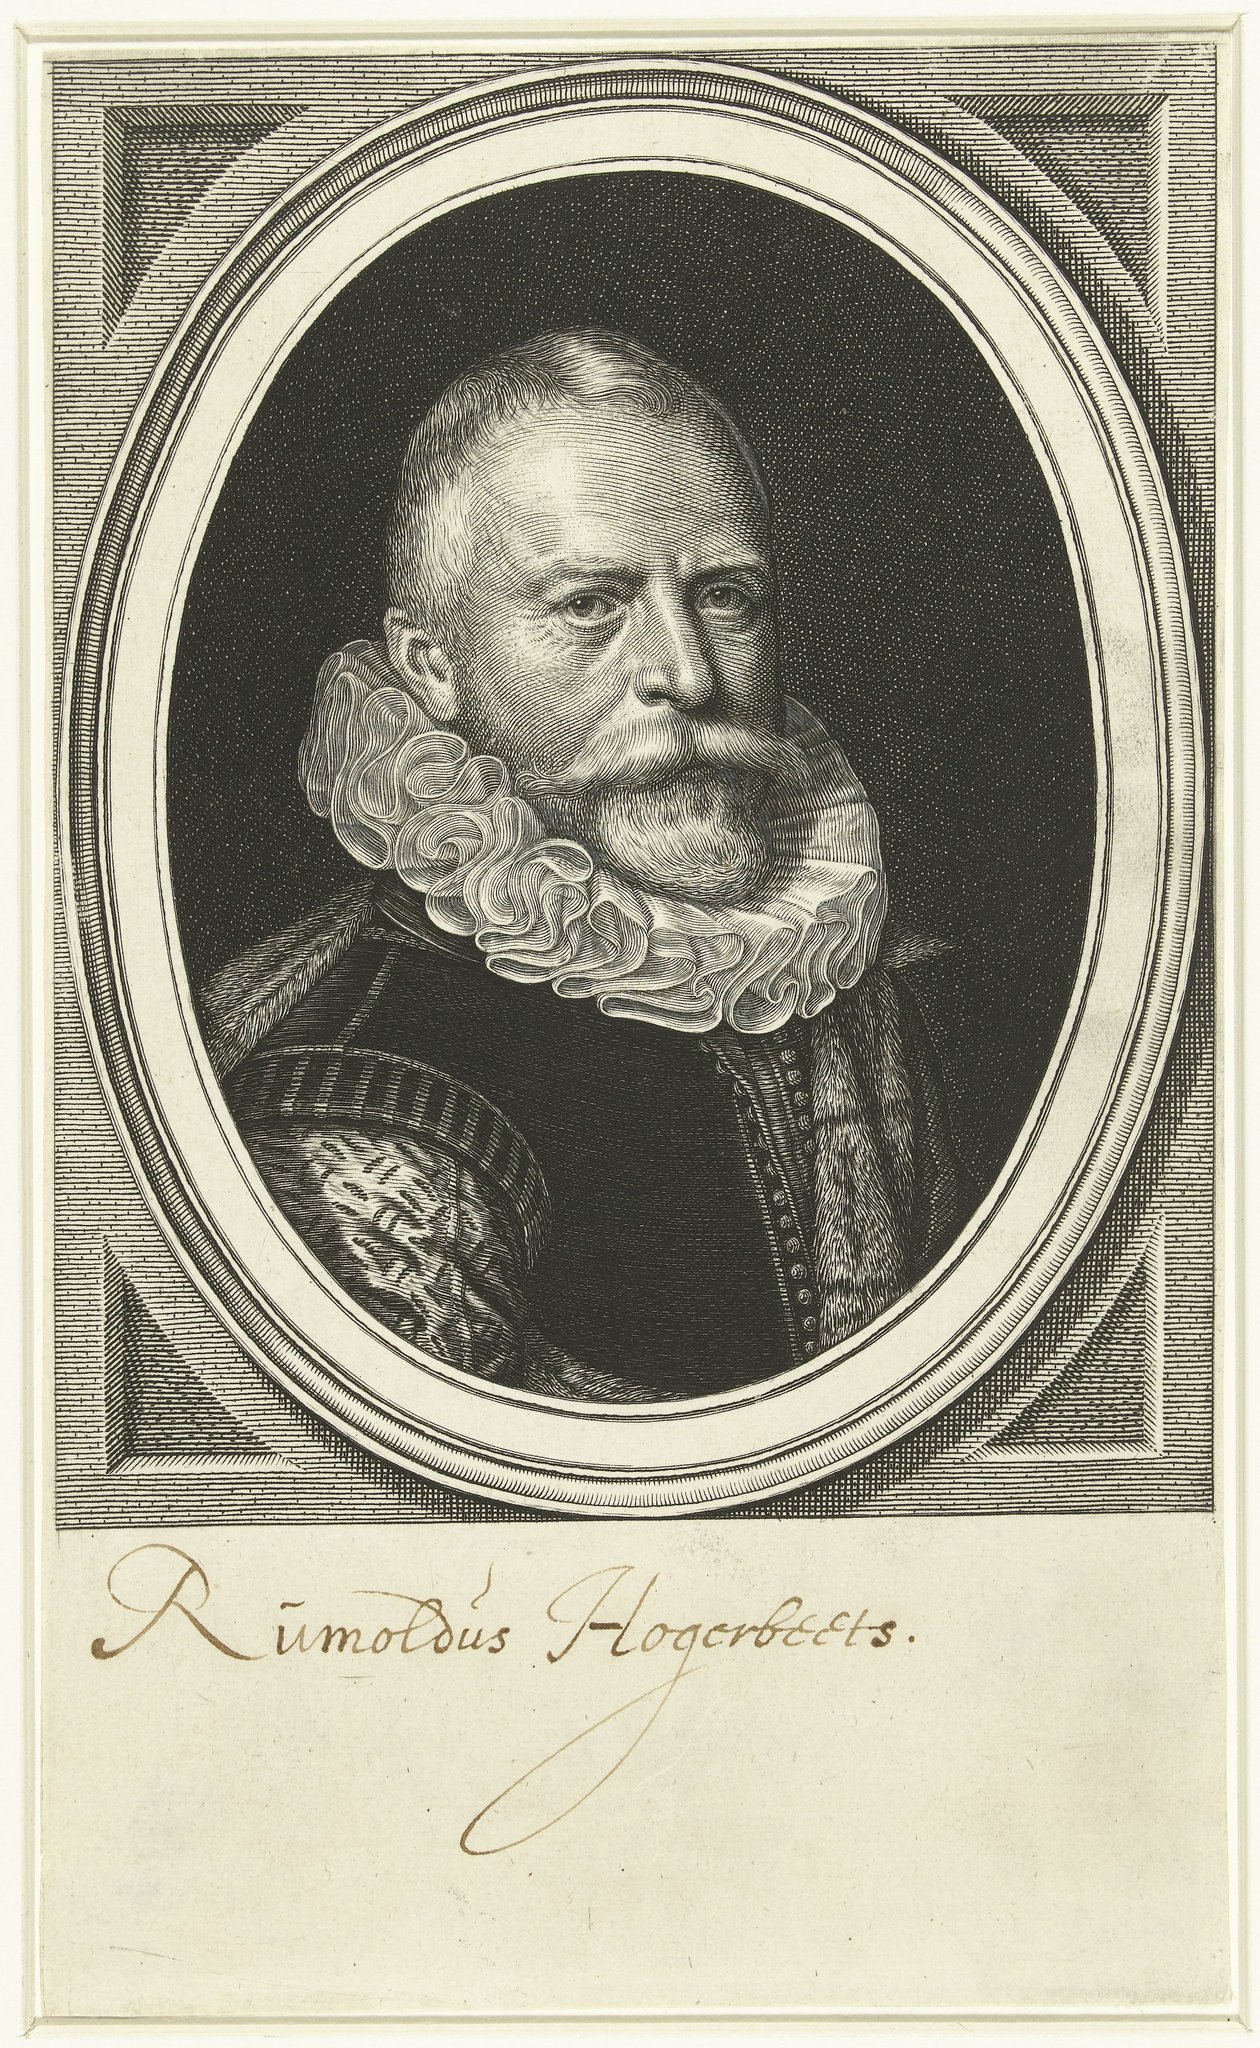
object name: print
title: Portret van pensionaris Rombout Hogerbeets op 58-jarige leeftijd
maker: willem jacobsz delff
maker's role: draughtsman, print maker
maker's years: 1580-1638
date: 1619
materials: paper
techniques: engraving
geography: delft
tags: wassenaar, staatsman, rombout hogerbeets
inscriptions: collector's mark: Lugt 240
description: Rombout Hogerbeets werd in 1619 veroordeeld tot levenslange gevangenschap op Slot Loevestein, samen met Hugo de Groot, vanwege zijn contacten met Johan van Oldebarnevelt. Deze prent werd volgens een plakkaat op 13 november 1619, in het jaar dat Delff hem vervaardigde, verboden voor de verkoop, zie notitie op los blad bij andere staten van dit portret.